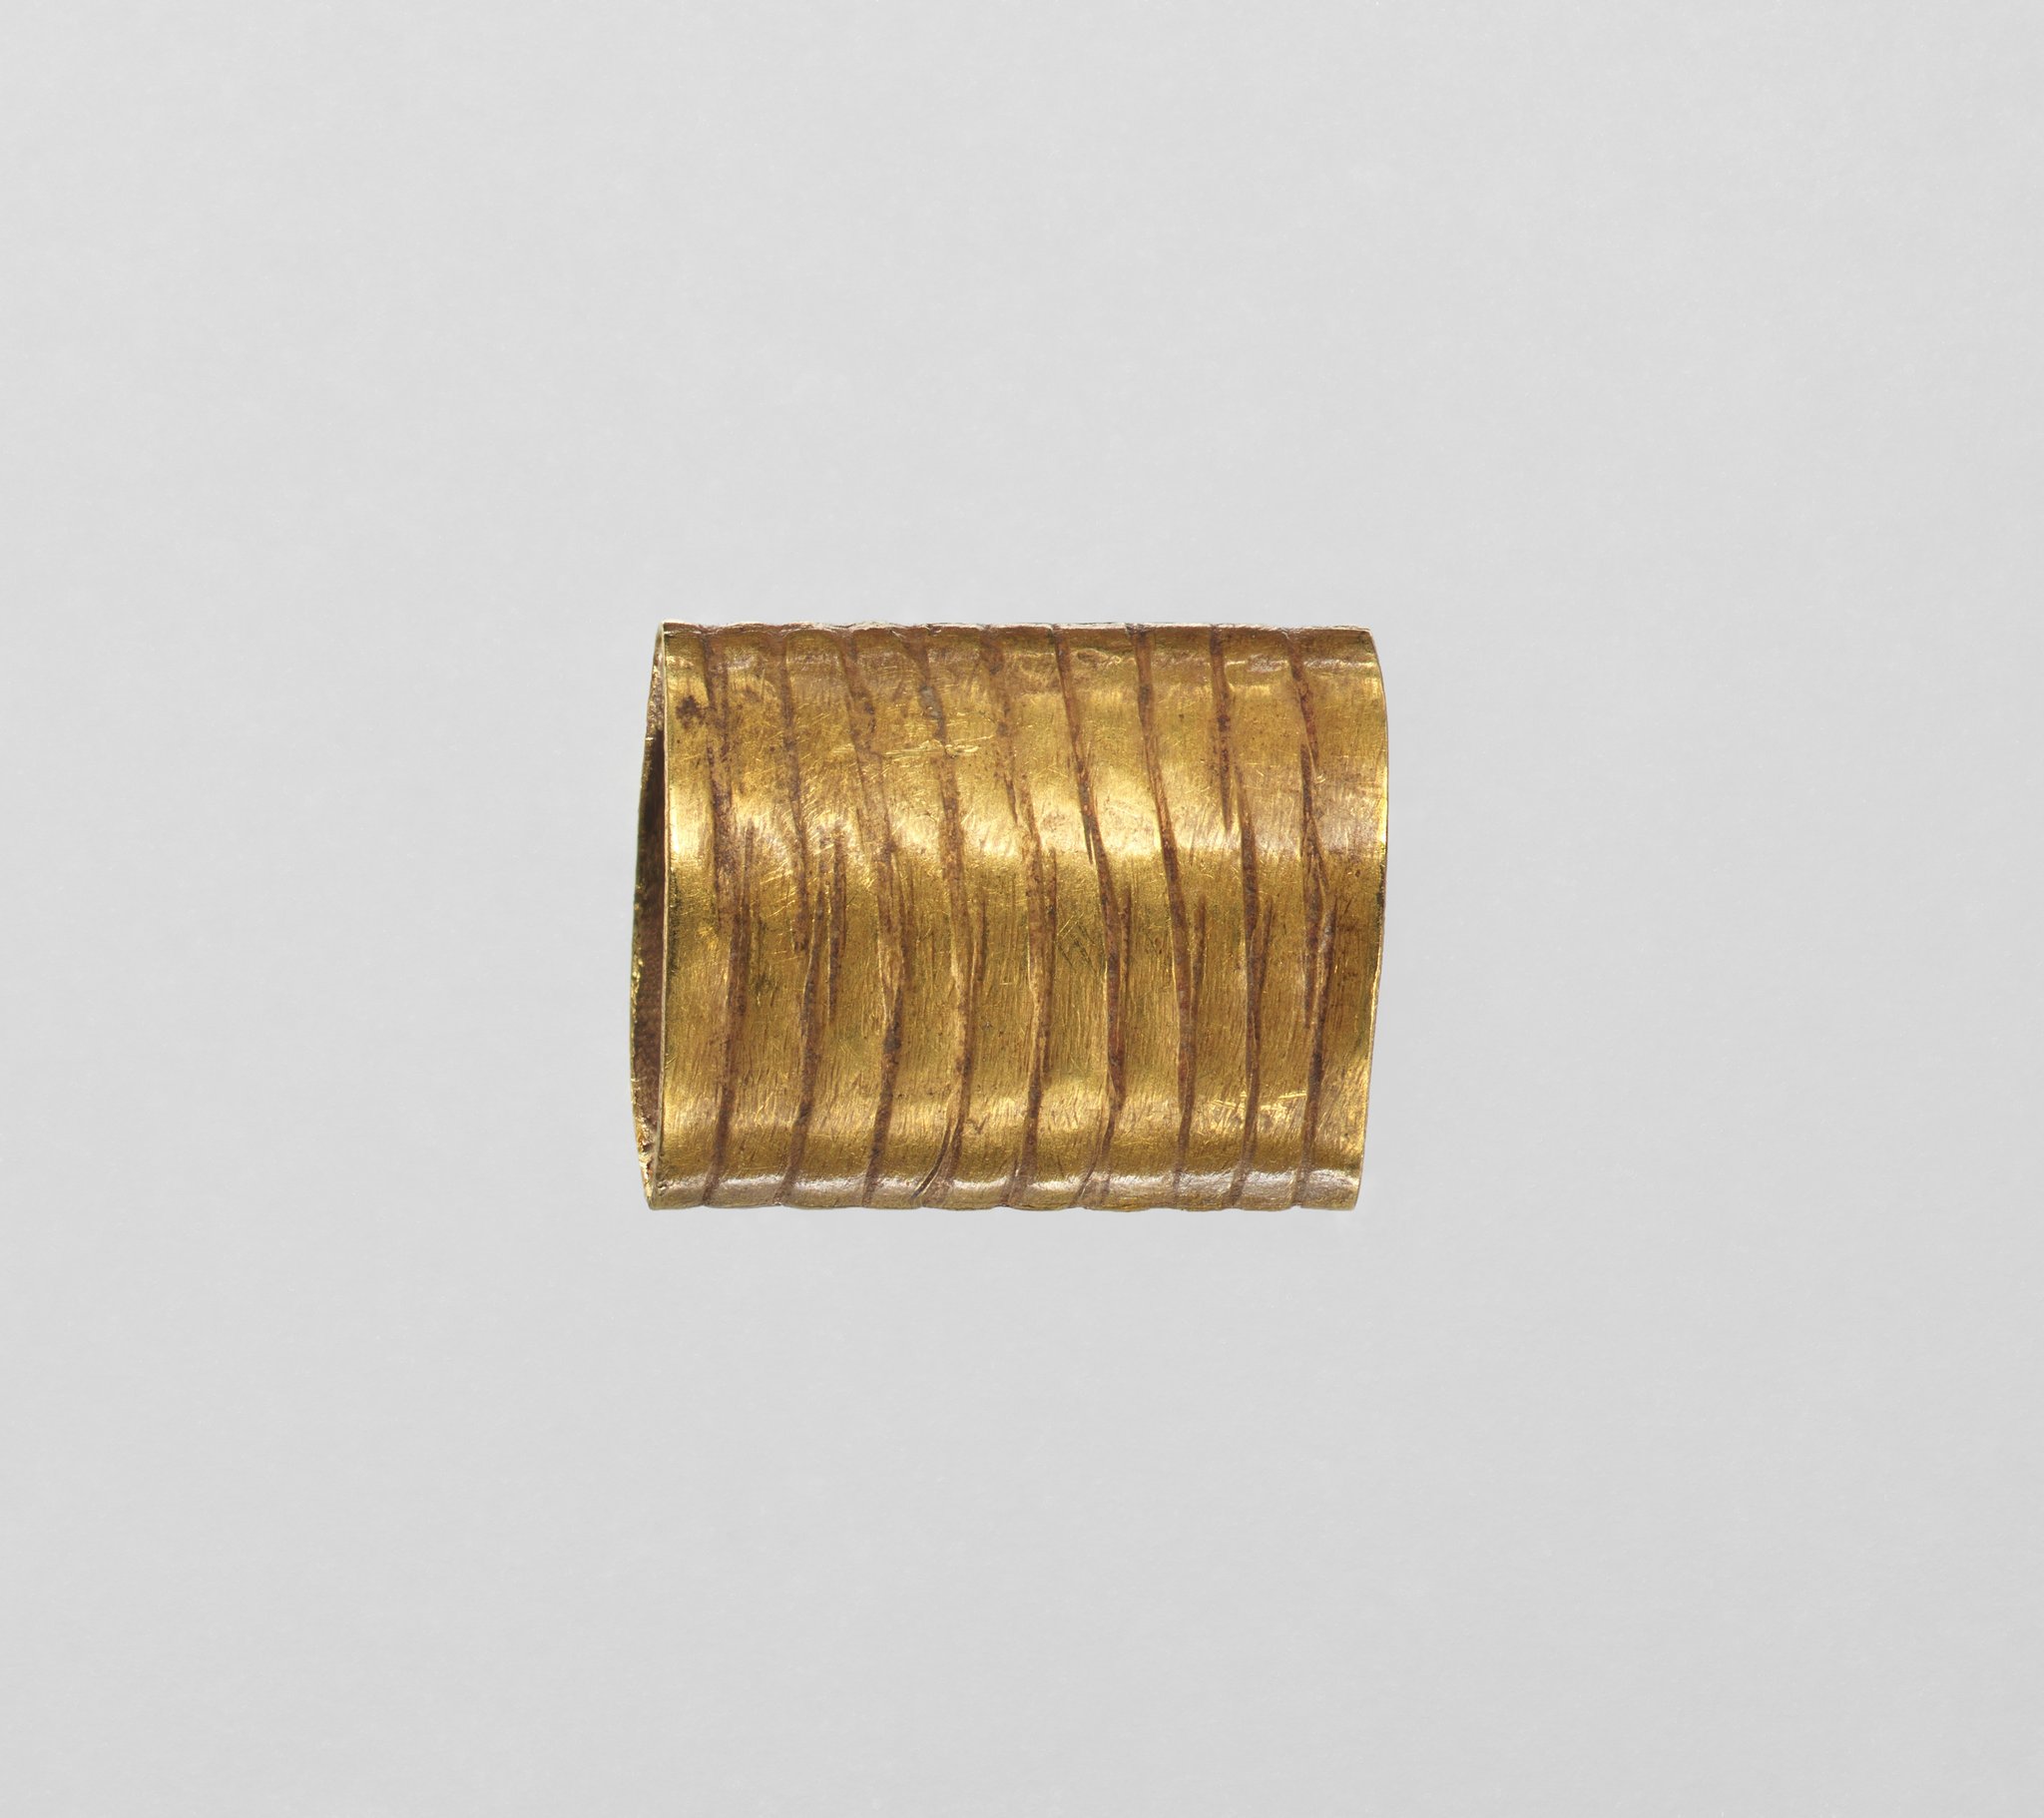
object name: ornament, wig tube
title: Wig tube (from a group of three)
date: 1878-1840 BCE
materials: gold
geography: memphite region